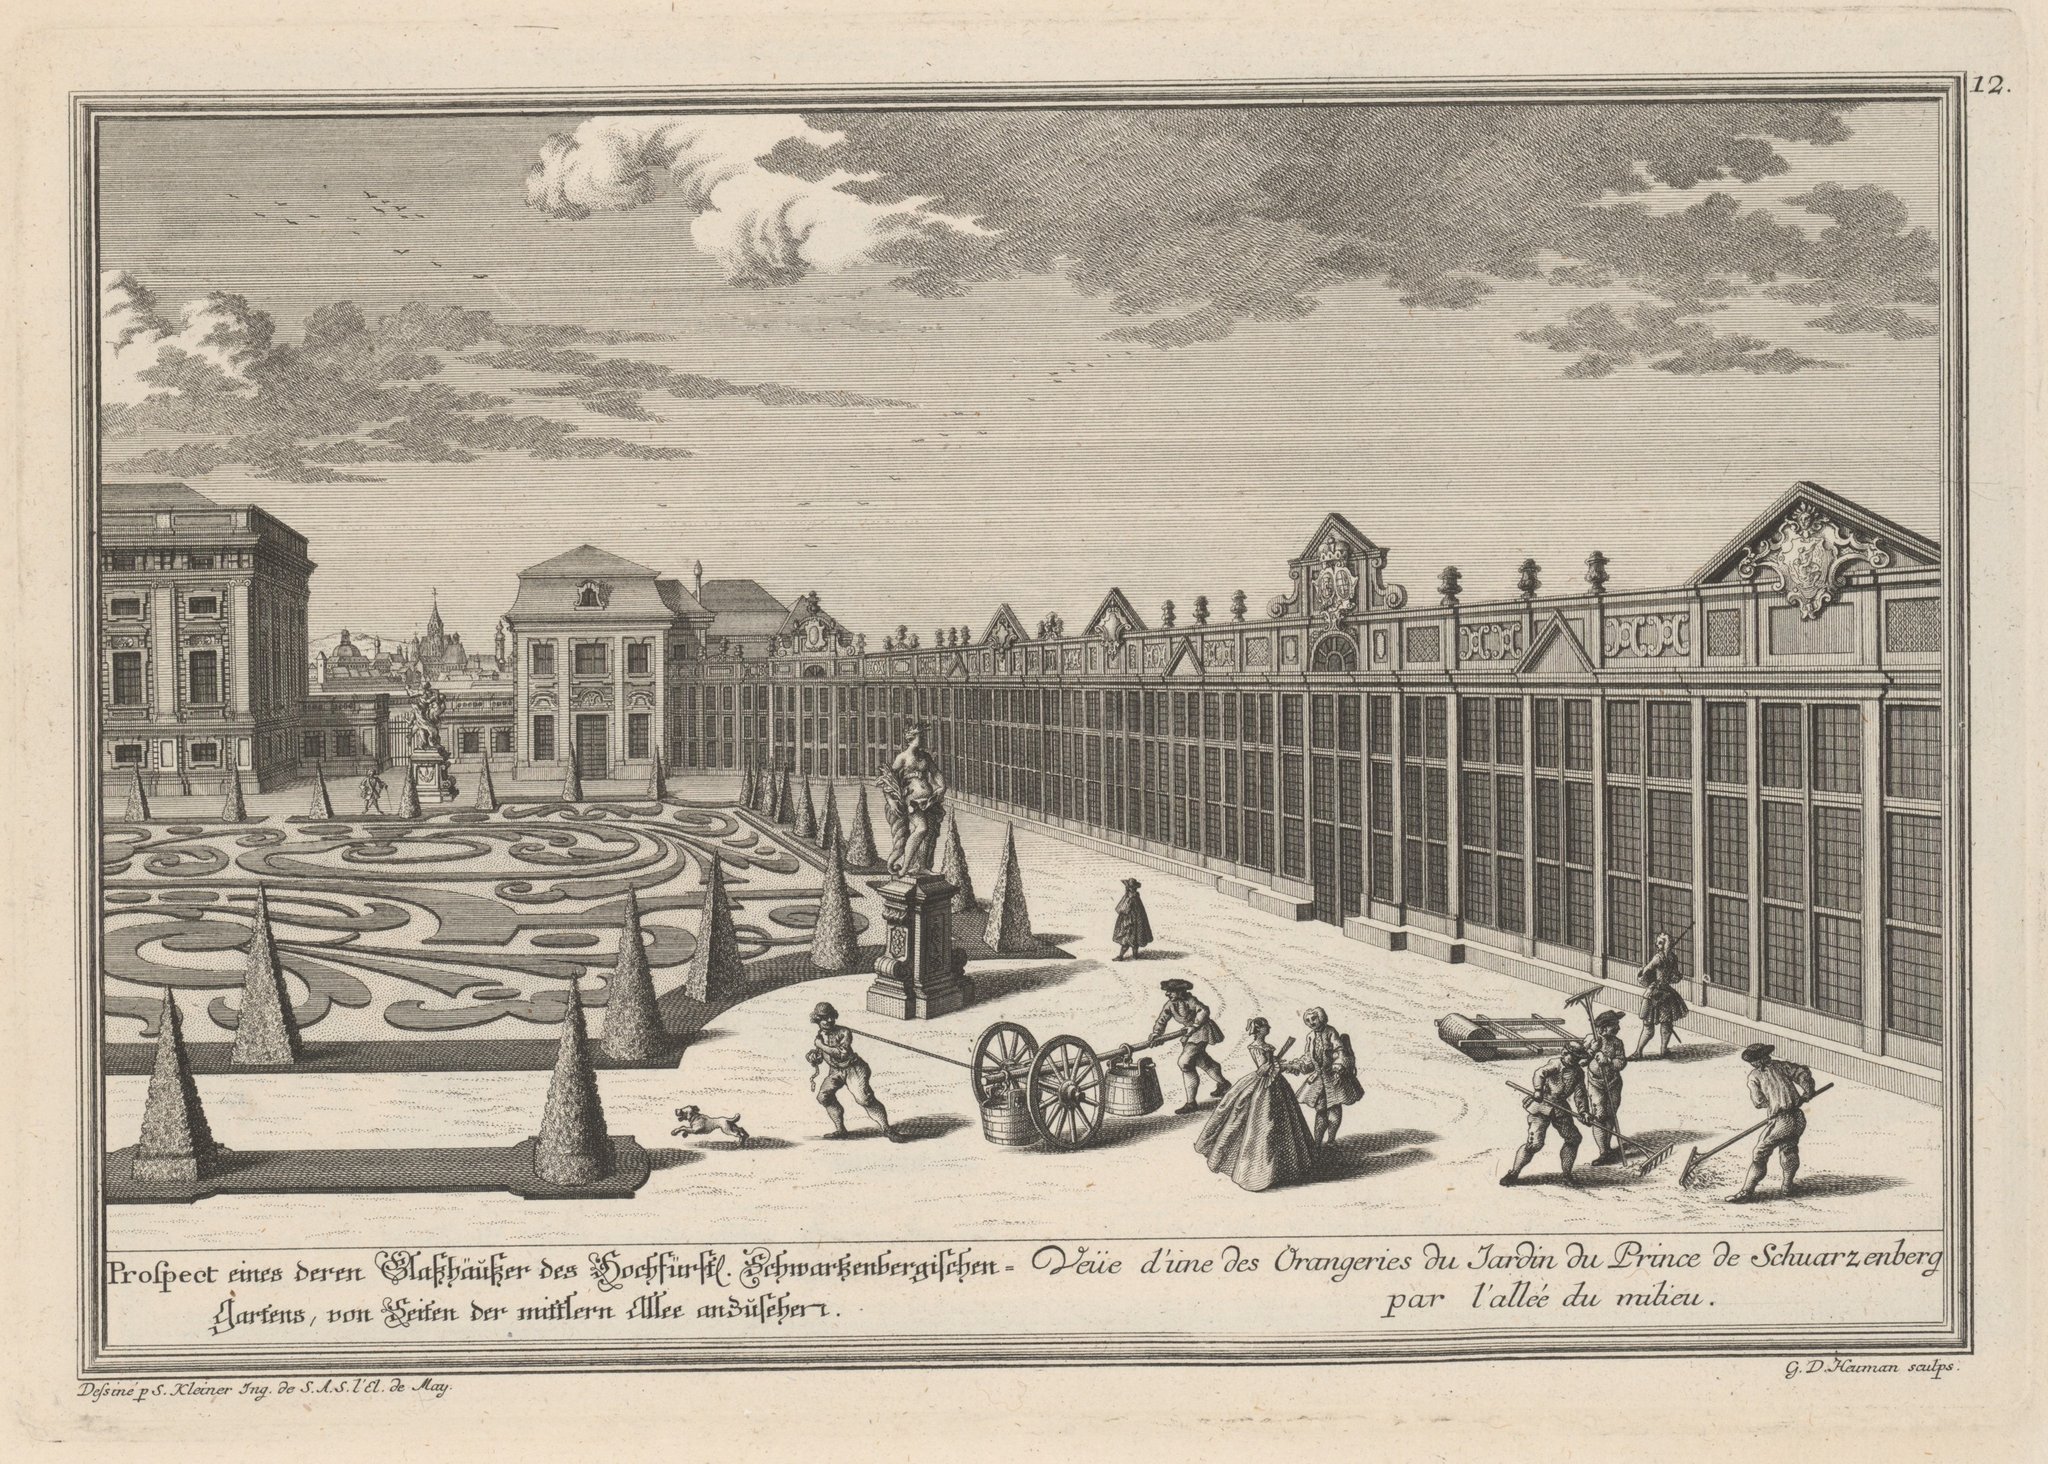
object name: book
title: Viererleÿ Vorstellungen angenehm-und zierlicher Grundrisse folgender Lustgärten ausser der Residenz-Stadt Wienn..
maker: salomon kleiner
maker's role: designer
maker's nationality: german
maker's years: 1700-1761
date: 1730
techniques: engraving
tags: gardens,working